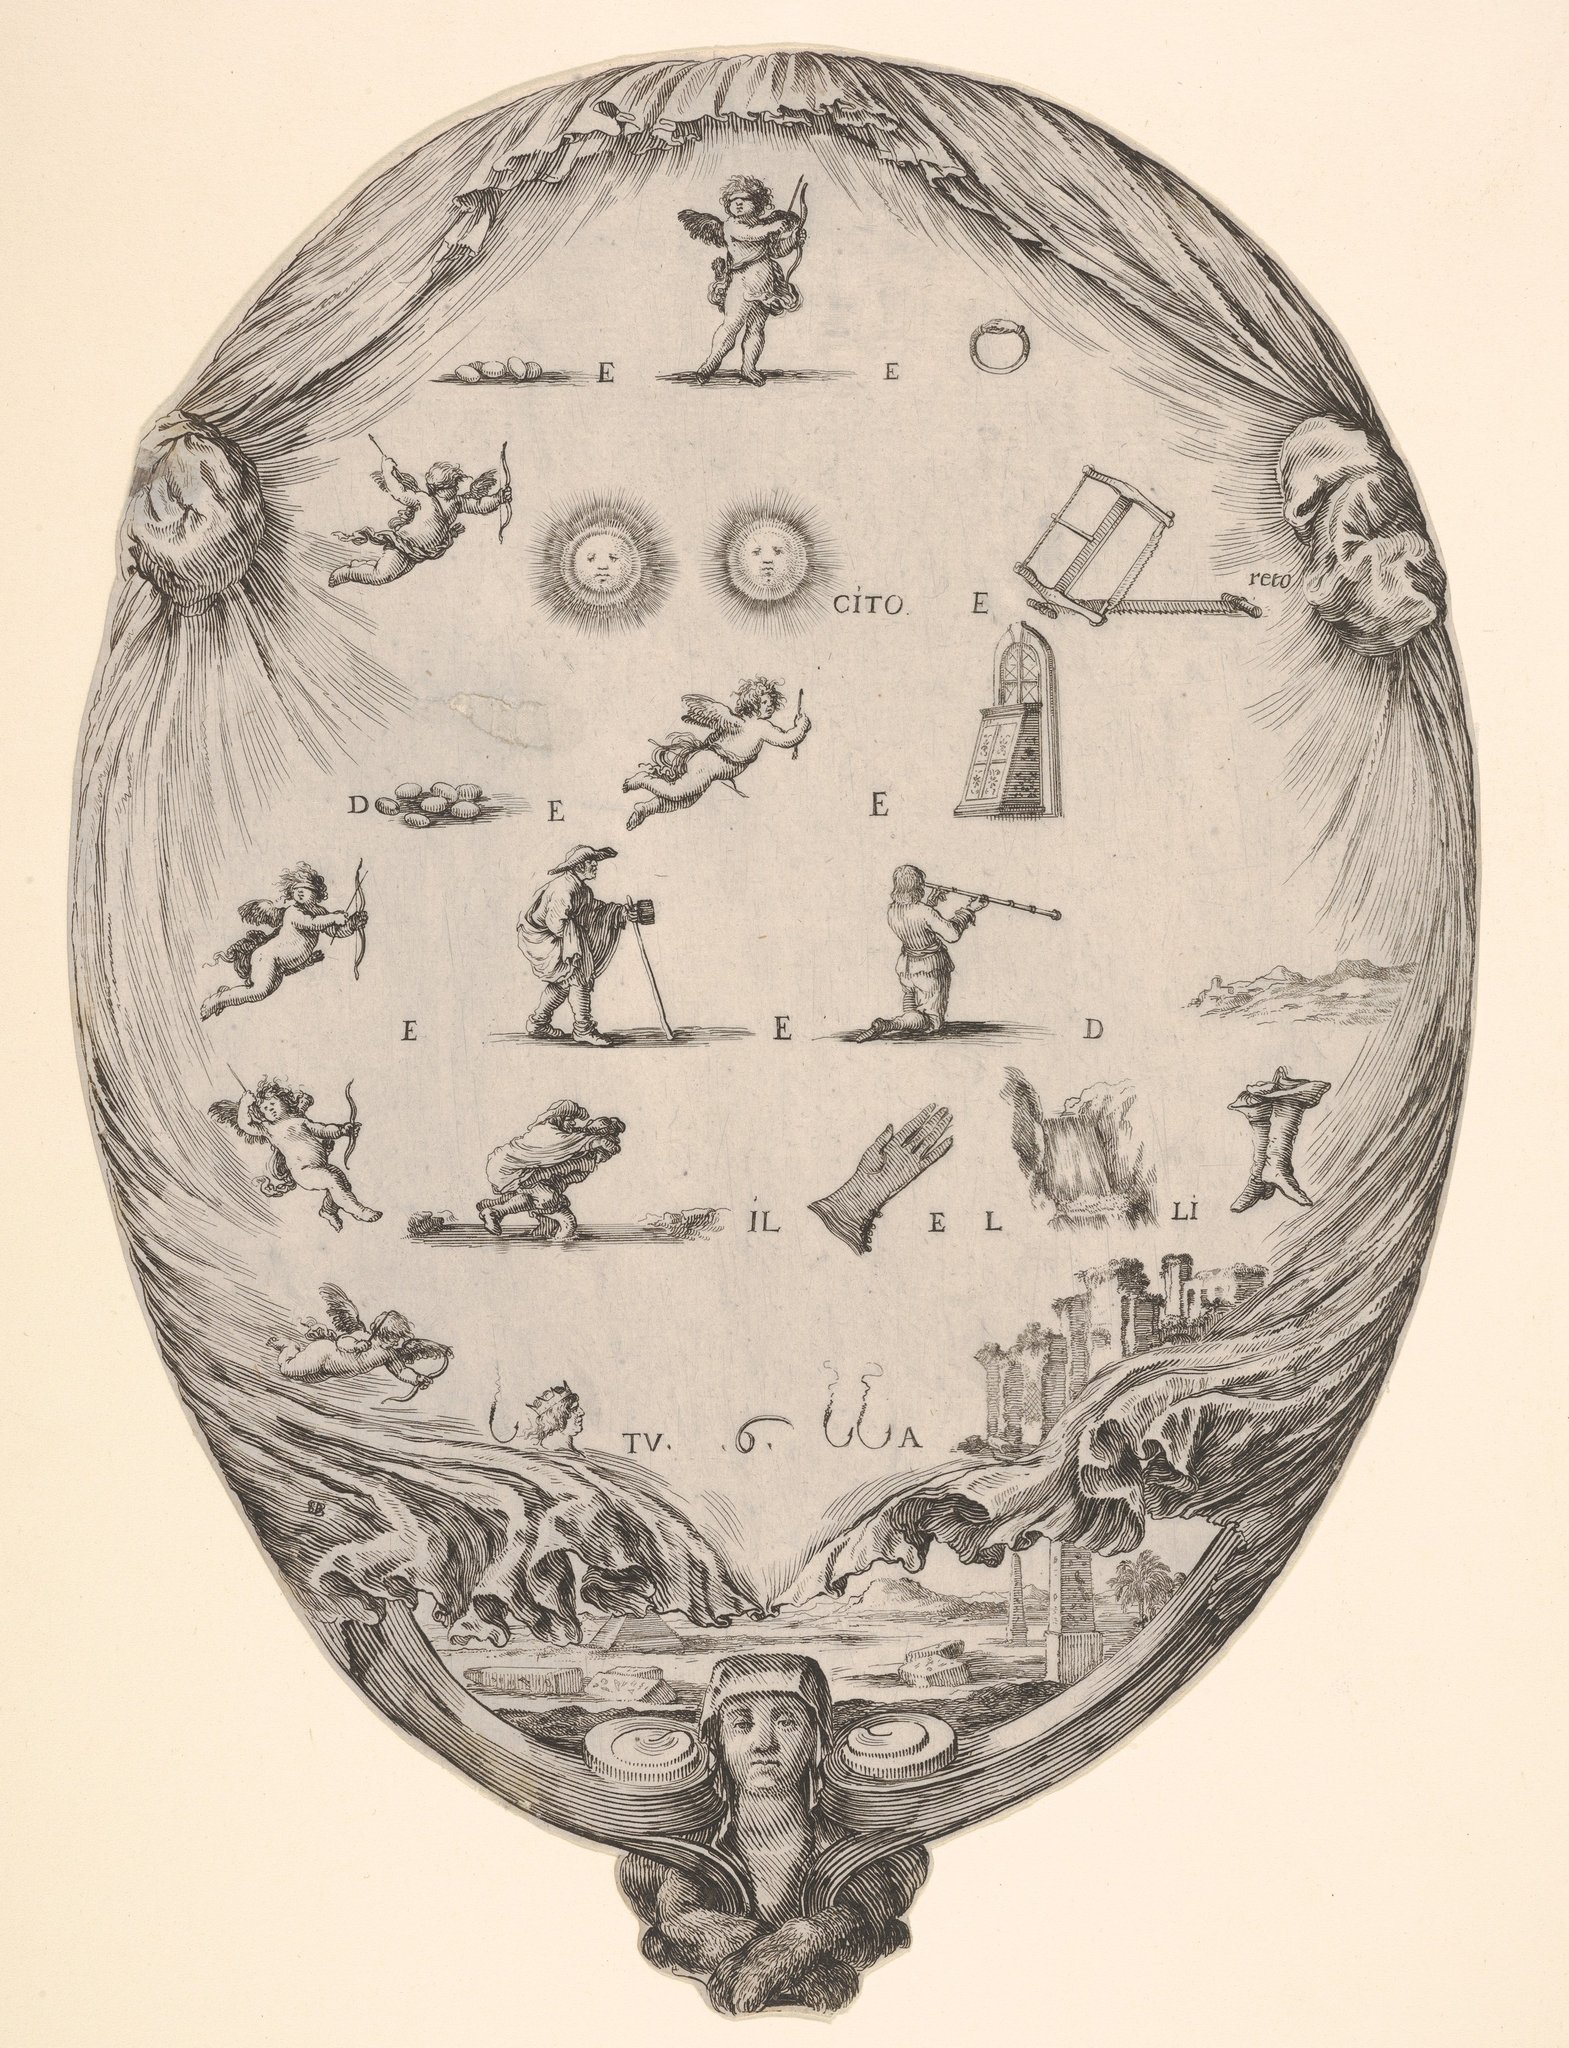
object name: print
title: Rébus on the subject of love, a riddle depicted on drapery, below a landscape with a pyramid and two obelisks, a bust of a sphinx at bottom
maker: stefano della bella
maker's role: artist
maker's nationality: italian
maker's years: 1610-1664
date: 1637-1642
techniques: etching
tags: obelisks,men,cupid,sphinx